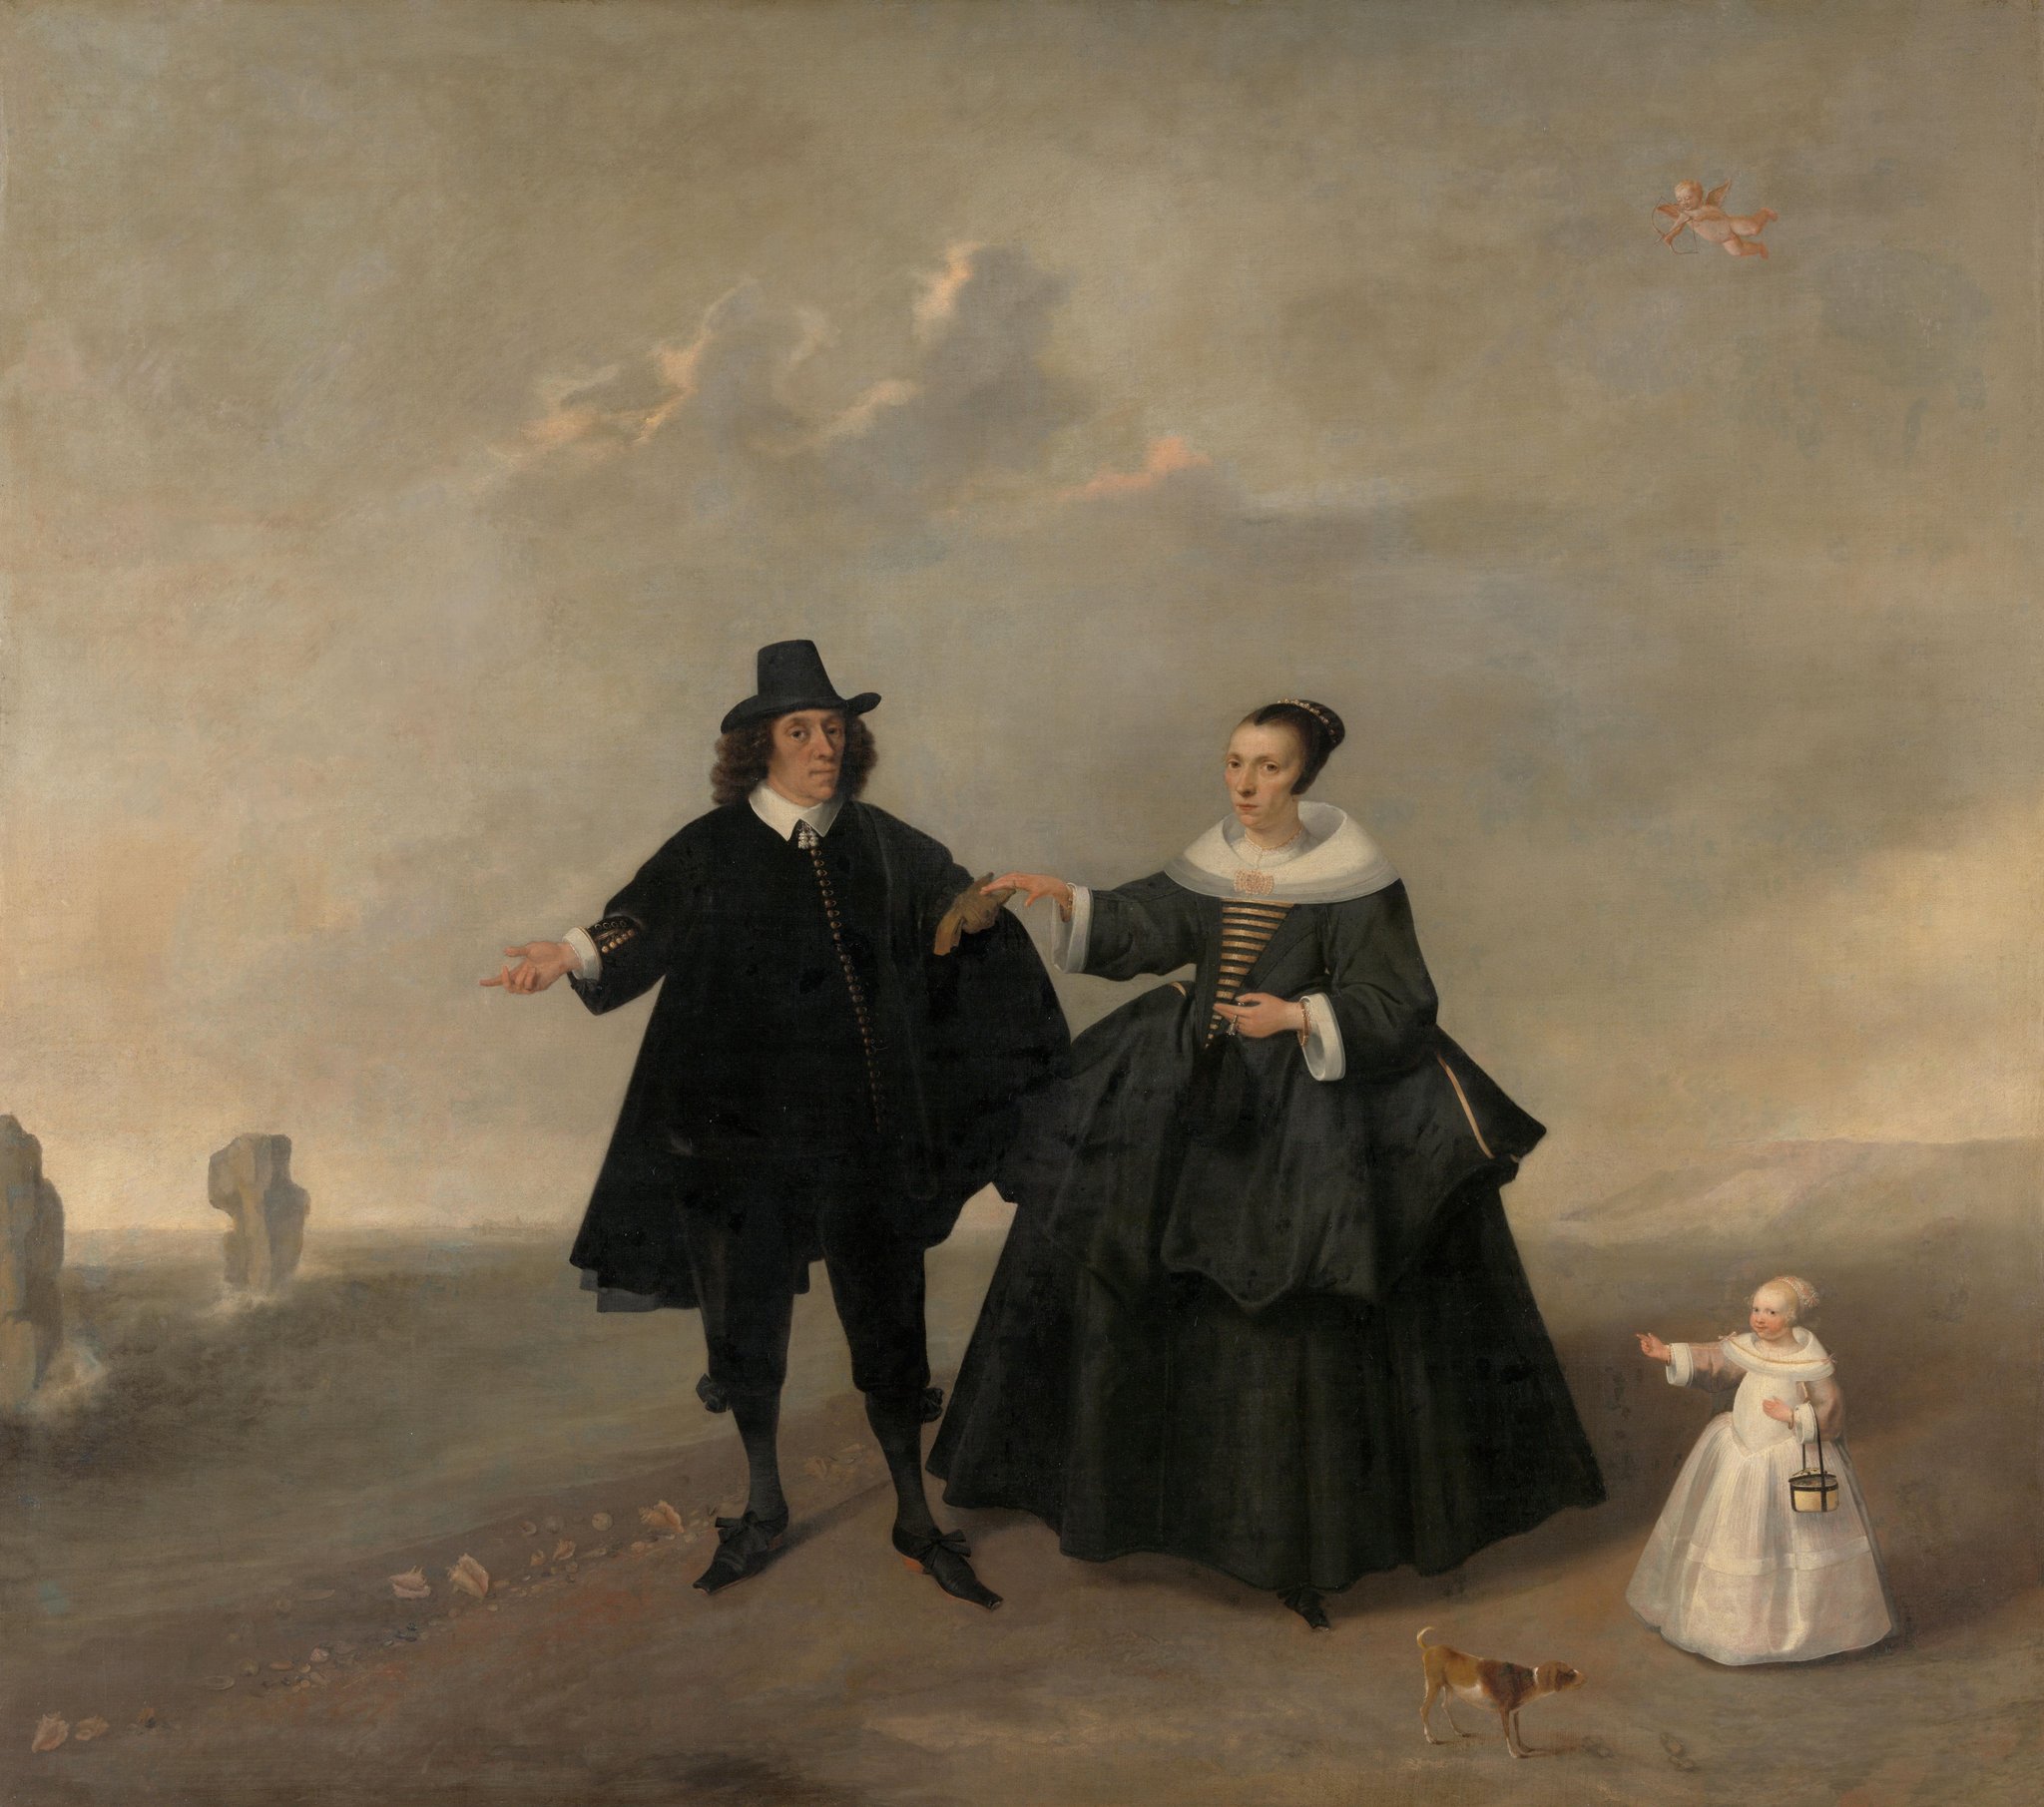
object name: painting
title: Portrait of a Married Couple with Child, Members of the Beresteyn Family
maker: Anonymous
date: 1655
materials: canvas, oil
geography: northern netherlands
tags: family group, especially parents with their child(ren)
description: Portret van een echtpaar met kind, leden van de familie van Beresteyn, staande aan het strand. Bij de vloedlijn liggen schelpen, het meisje heeft een mandje om de arm, voor haar staat een hond.